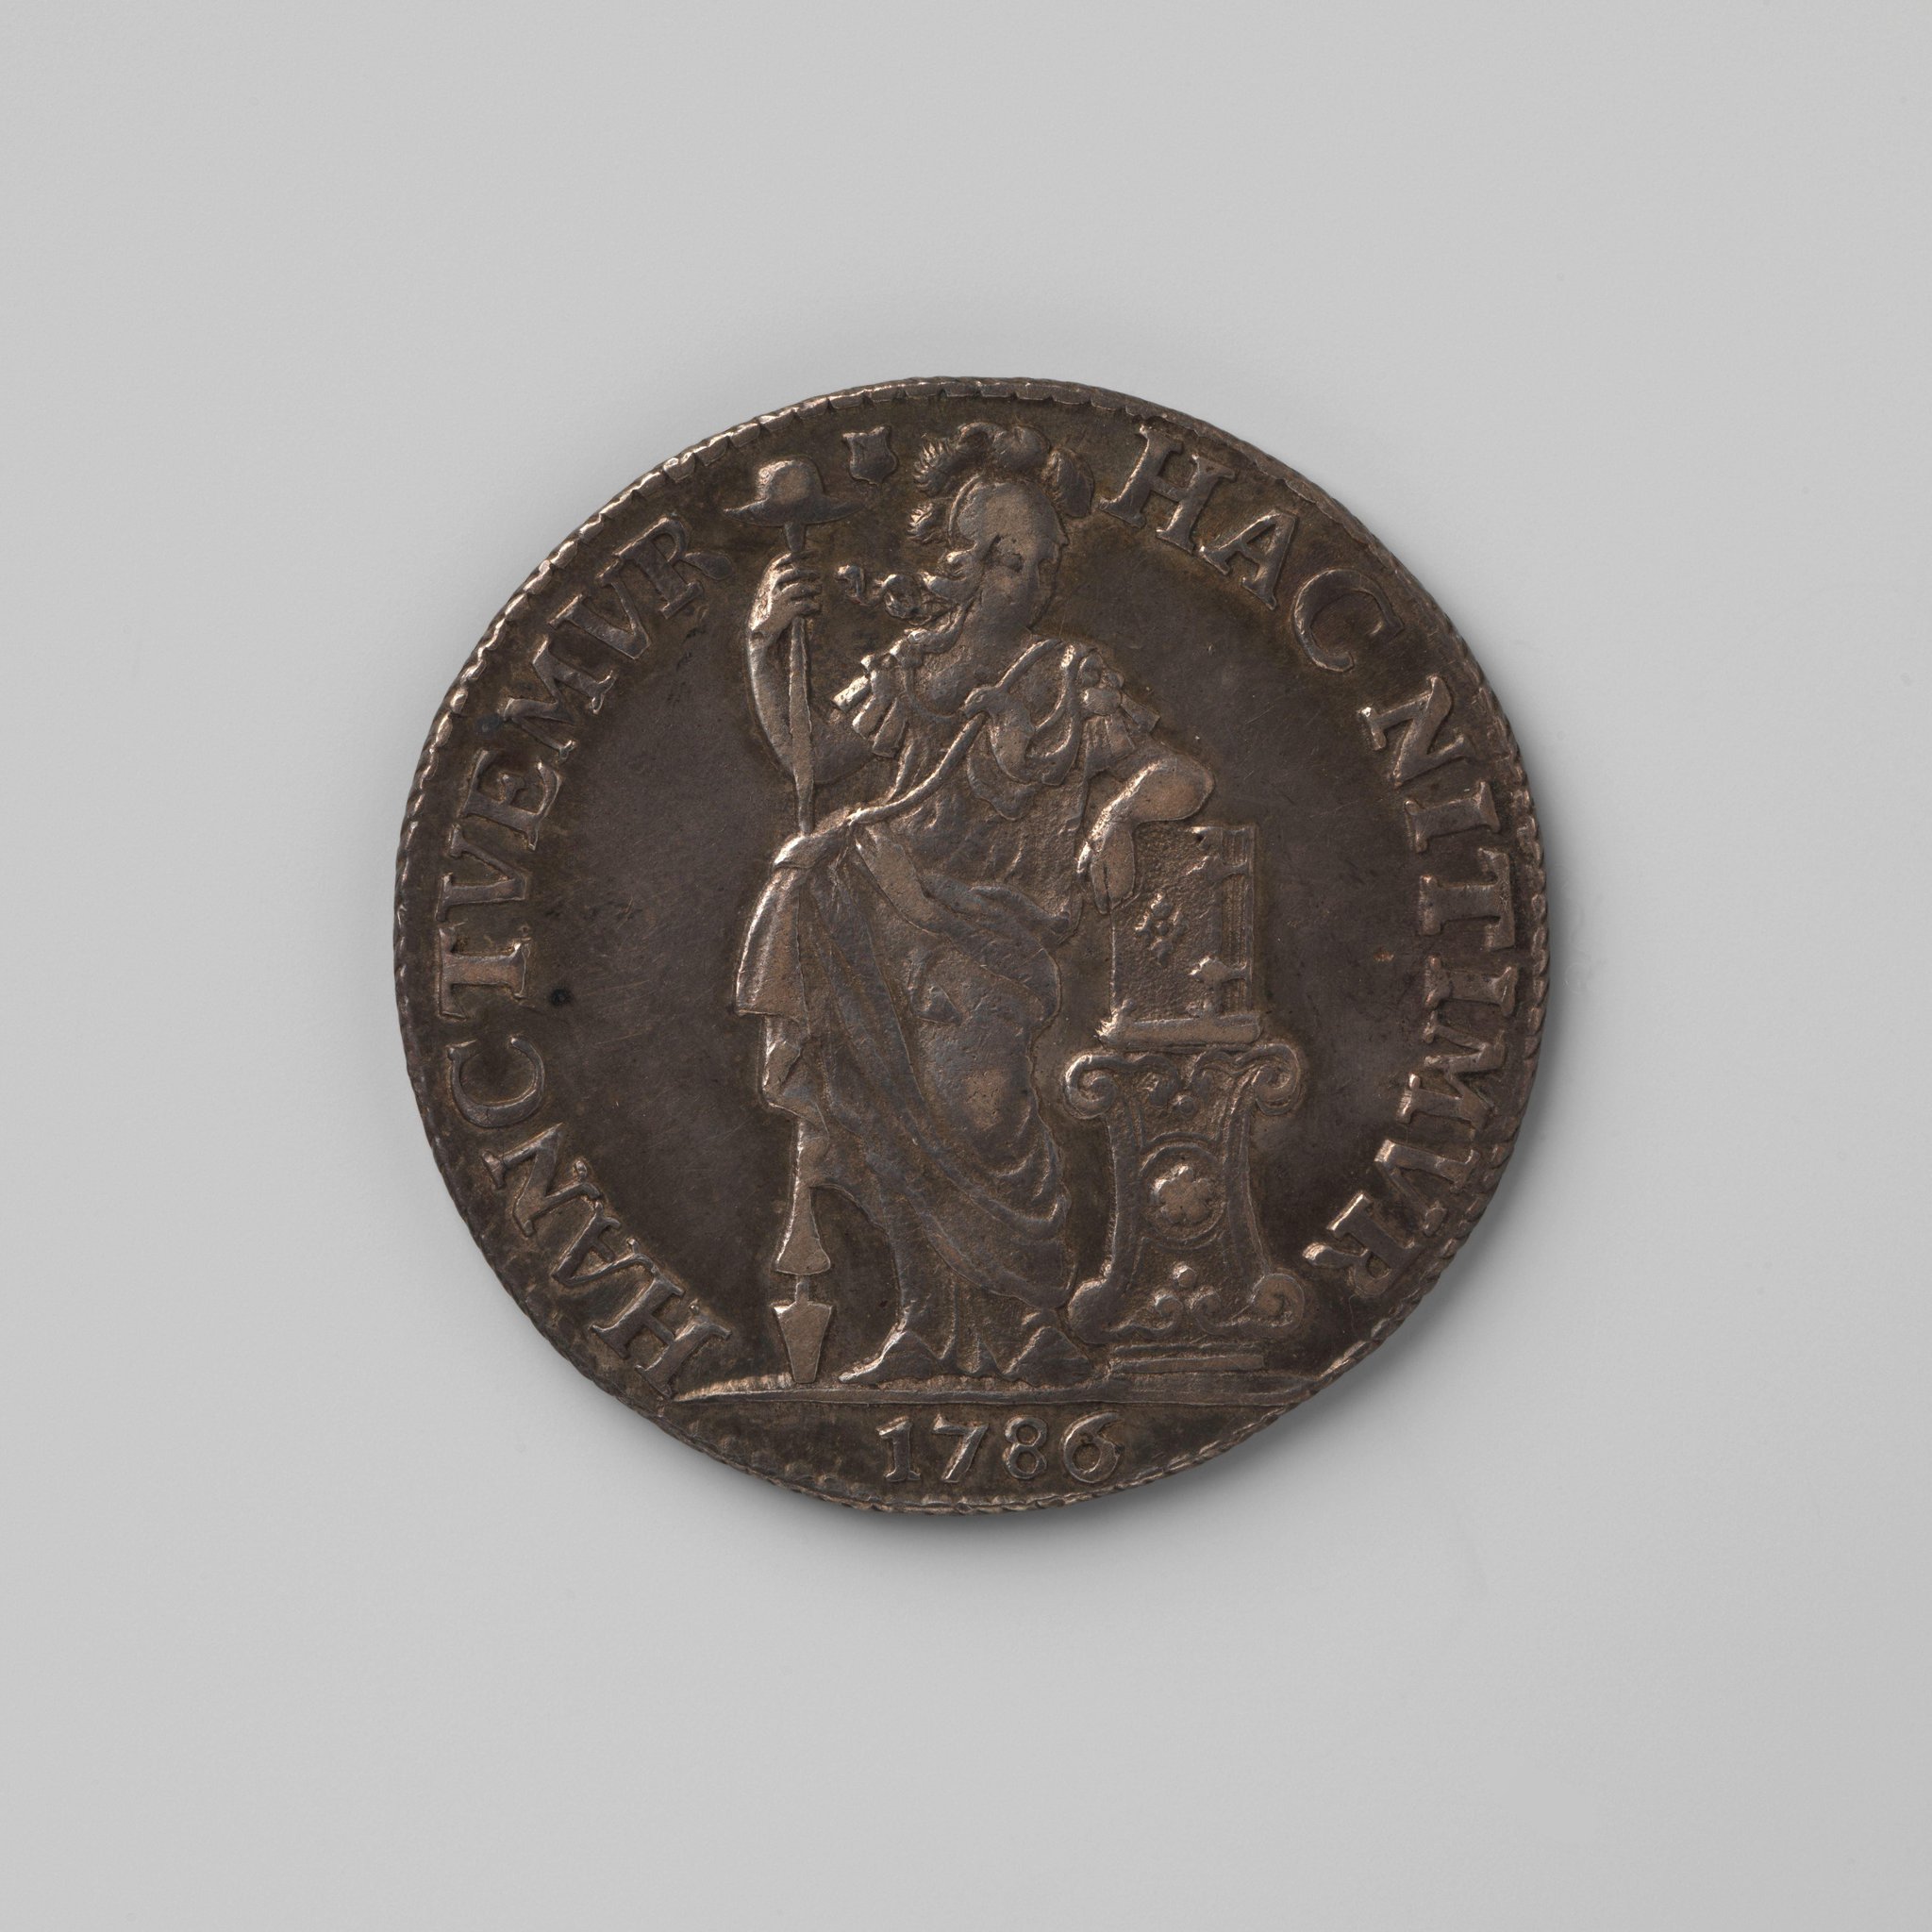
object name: coin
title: Gulden van de VOC uit Utrecht, 1786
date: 1786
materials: silver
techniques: striking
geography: utrecht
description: Zilveren munt. Voorzijde: tussen waarde-aanduiding 1 G gekroond generaliteitswapenschild, waaronder monogram van de VOC. Keerzijde: Nederlandse maagd met speer, waarop vrijheidshoed, leunend op een bijbel op een altaar. Jaartal in afsnede. Kabelrand.